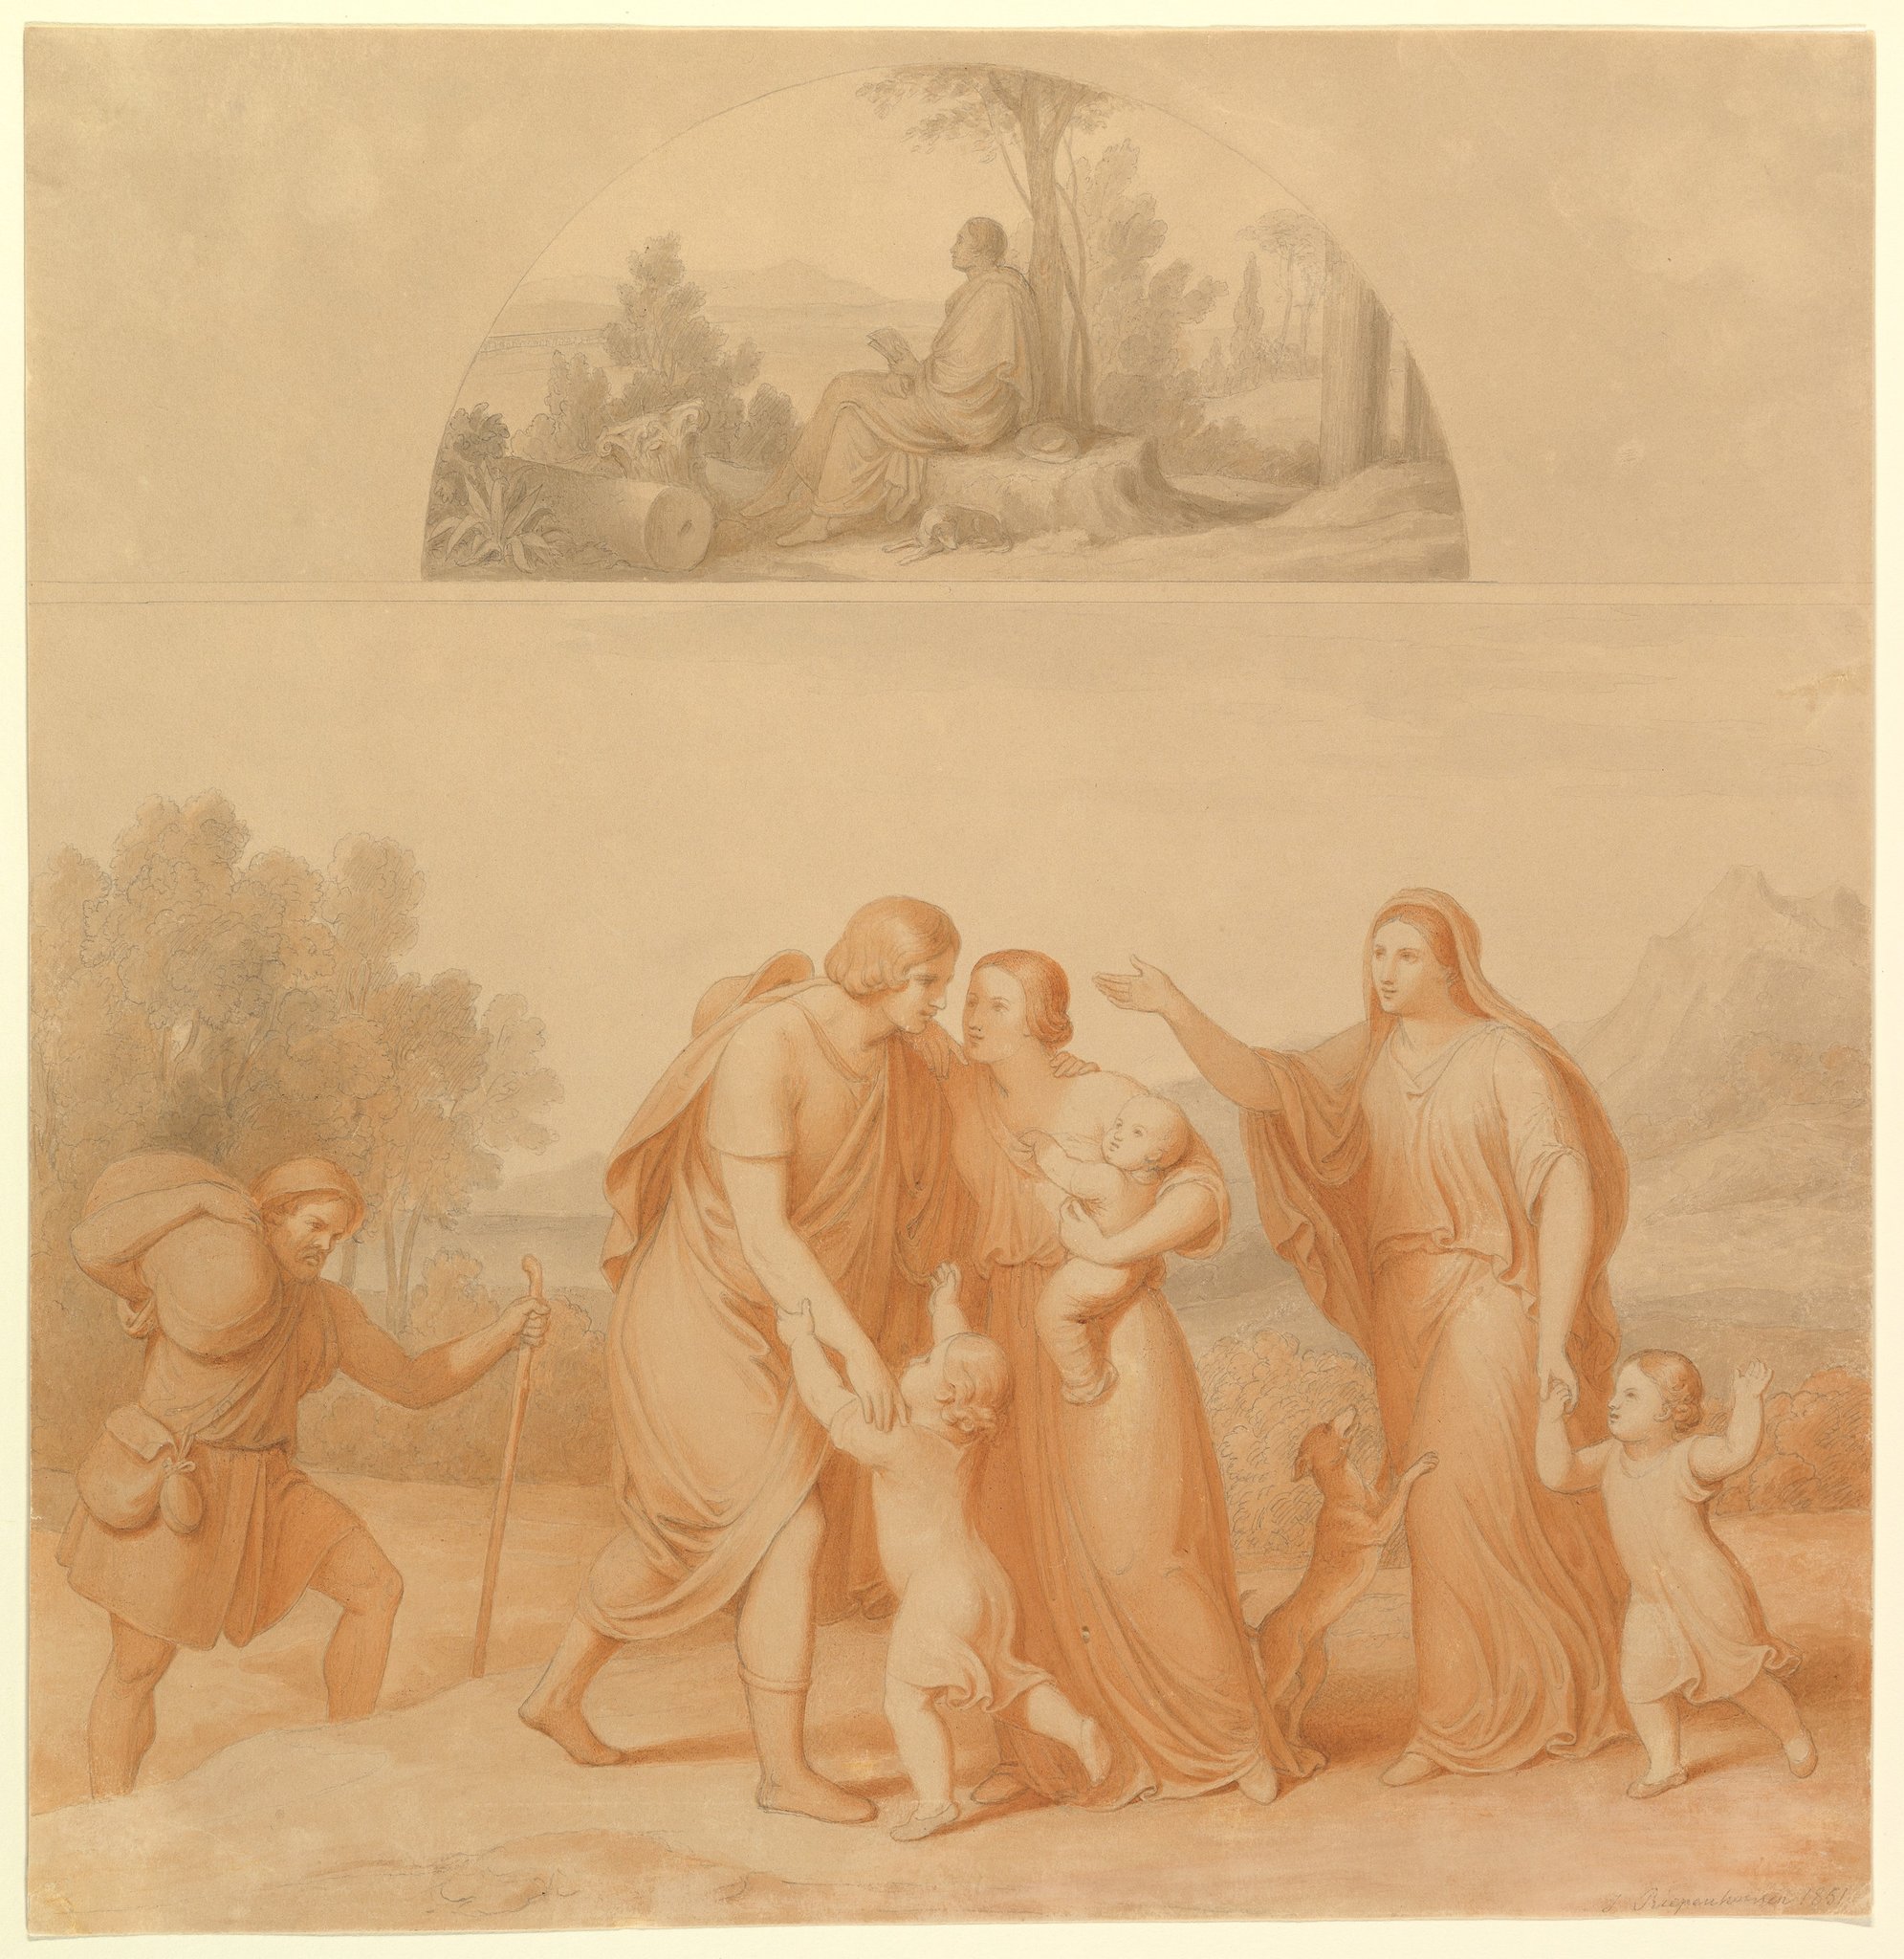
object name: drawing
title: "The Return"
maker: johannes riepenhausen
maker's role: artist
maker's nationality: german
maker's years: 1788-1860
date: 1767-1900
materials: chalk, graphite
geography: germany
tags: children,men,women,dogs